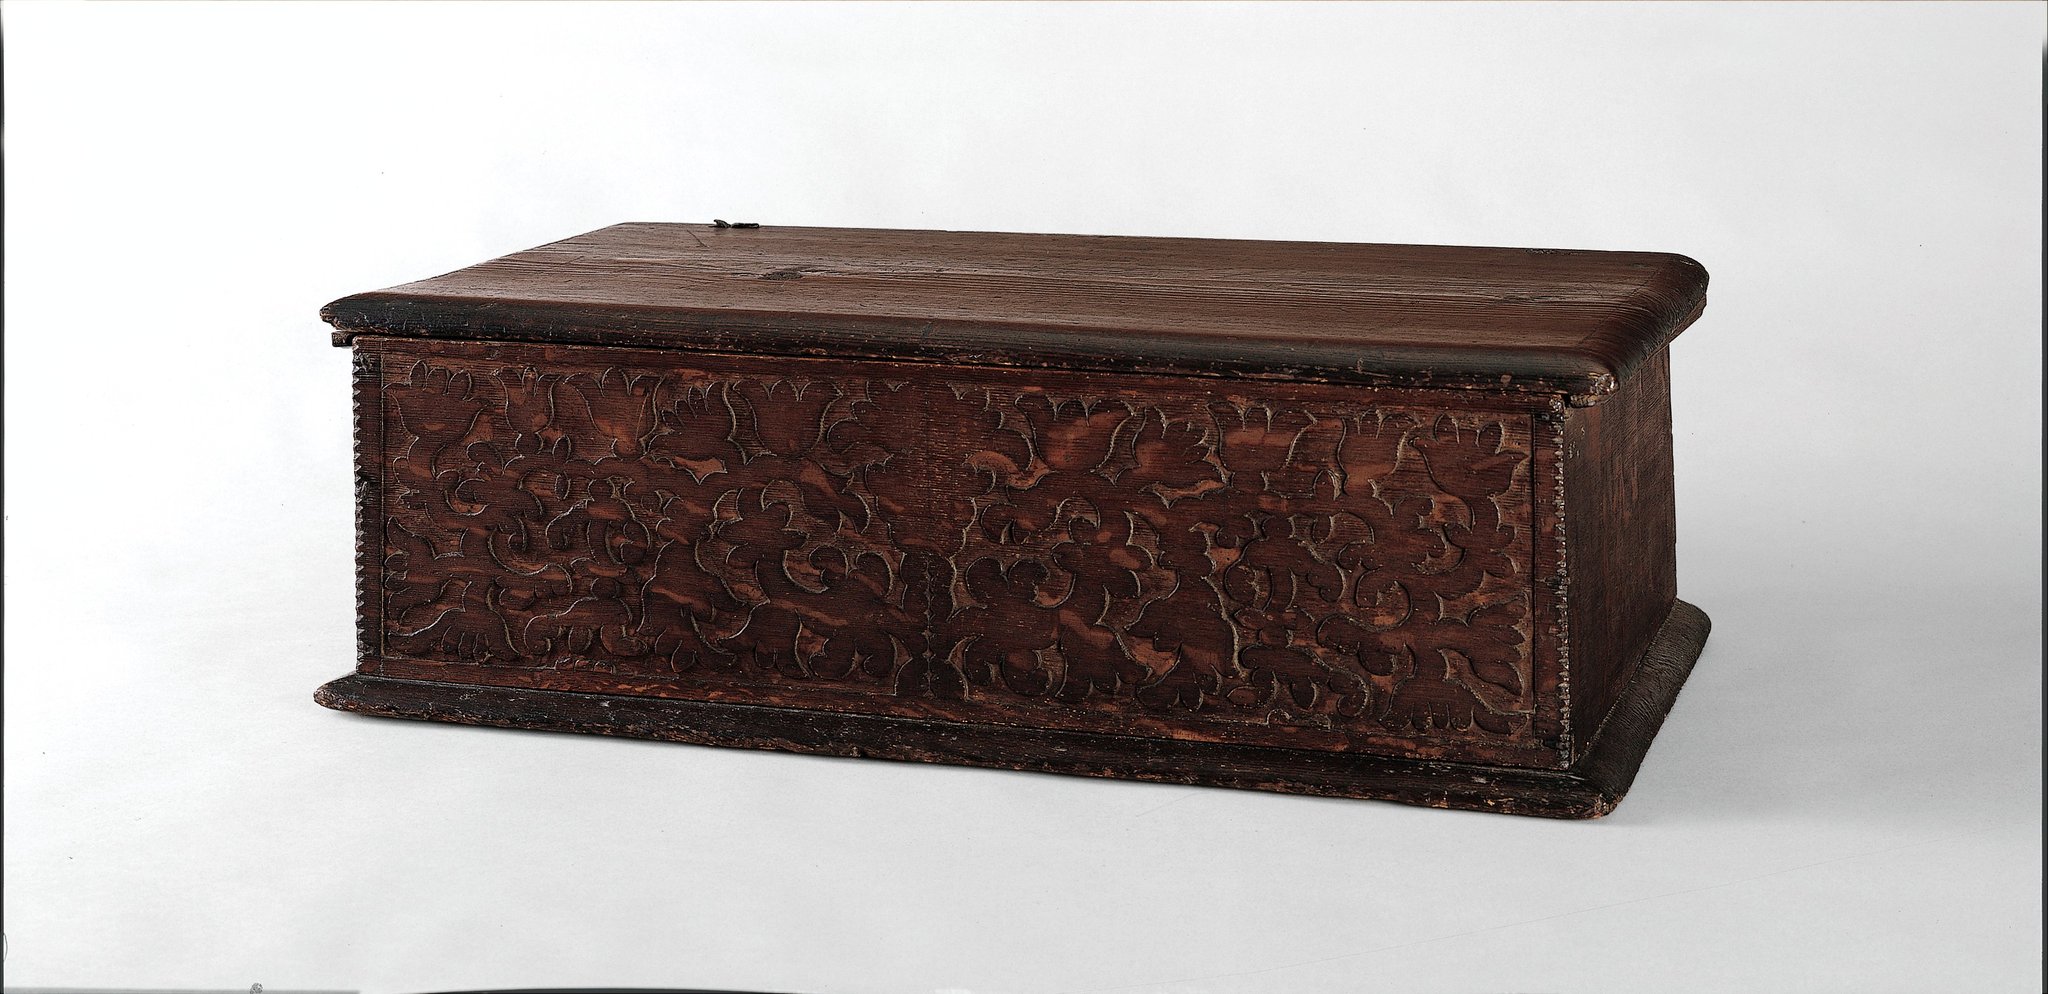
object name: box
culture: american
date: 1675-1700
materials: wood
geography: united states